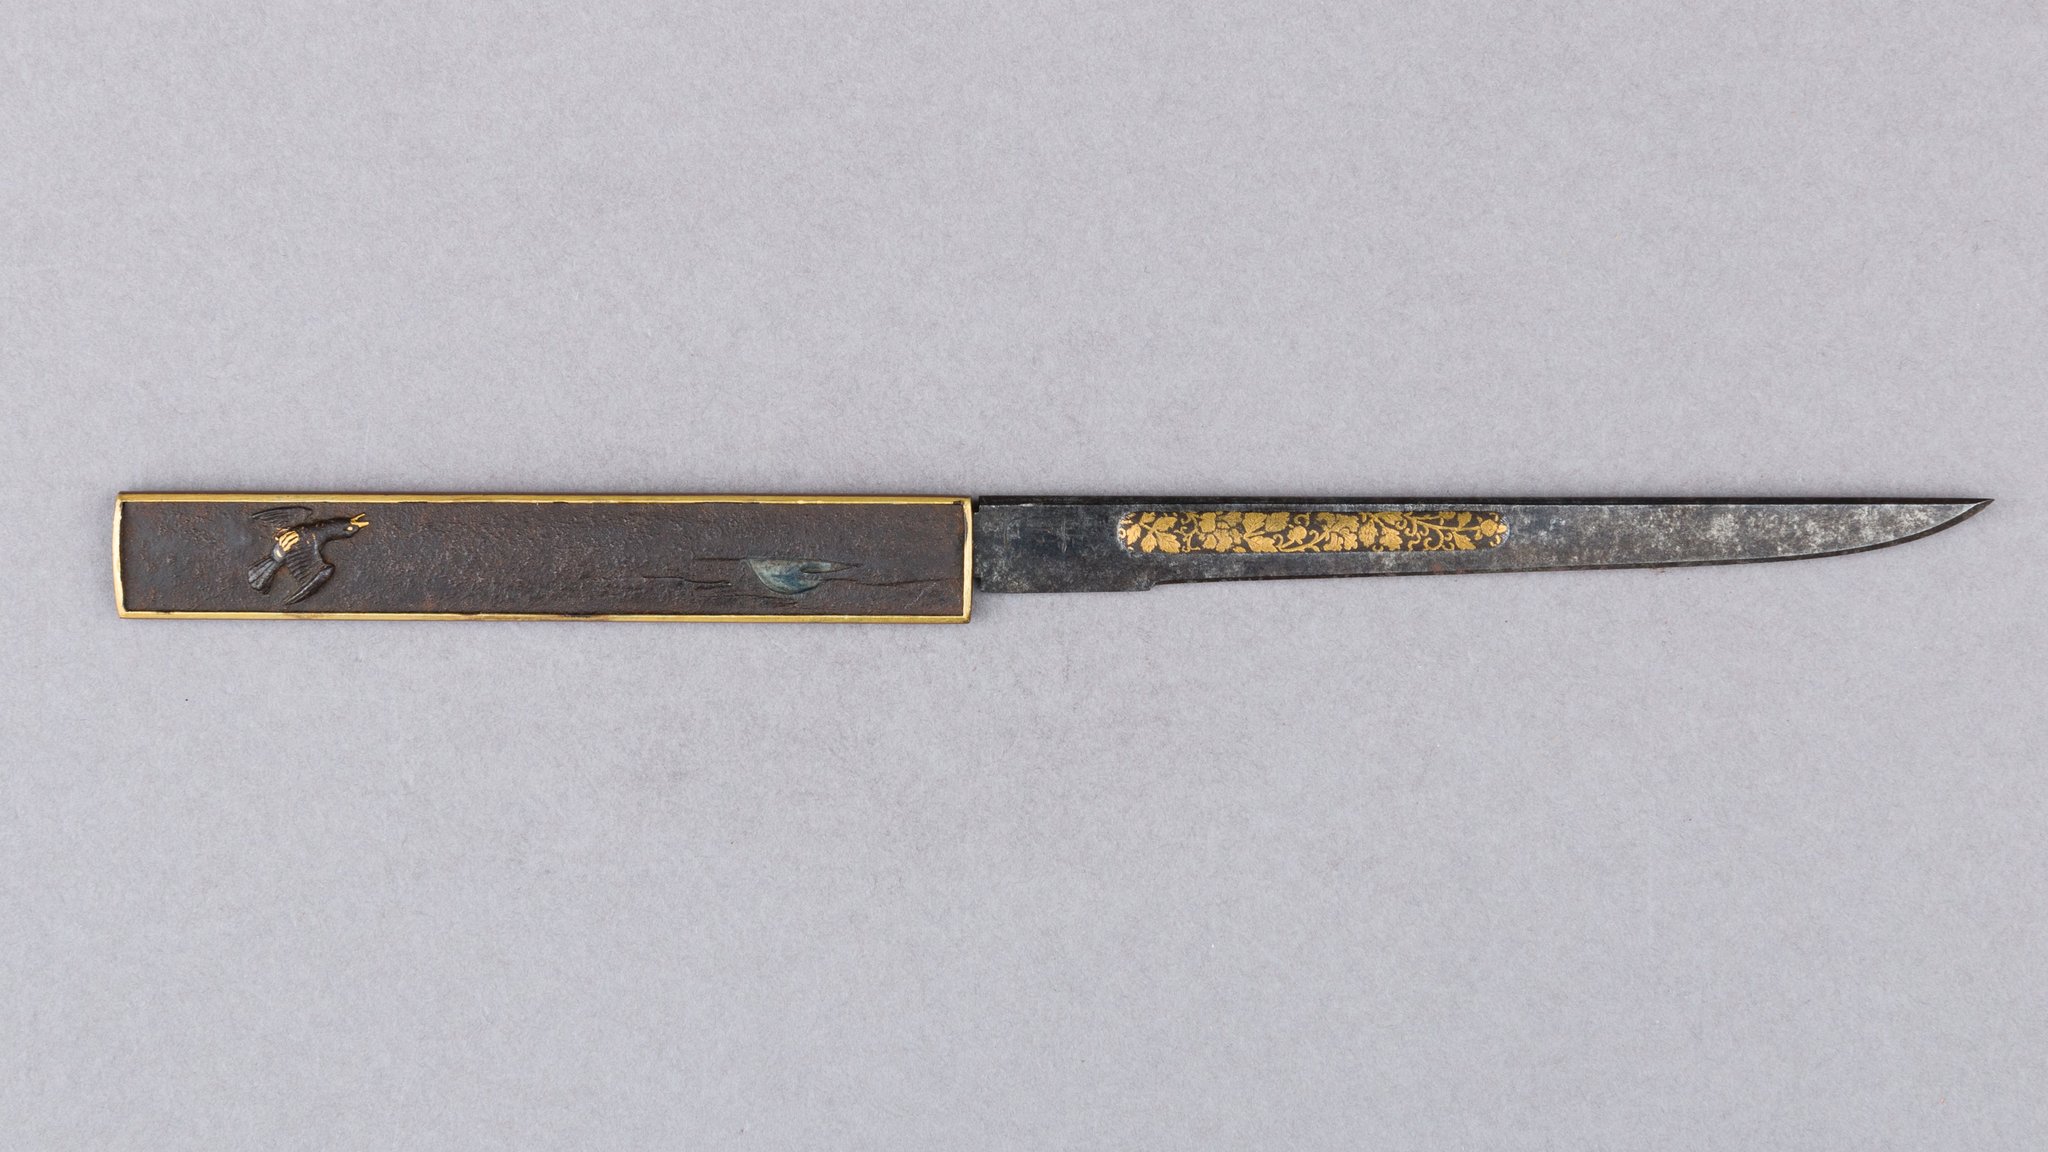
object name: knife handle kozuka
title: Knife Handle (Kozuka) with Blade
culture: japanese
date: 1701-1800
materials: copper, silver alloy, gold, iron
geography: japan